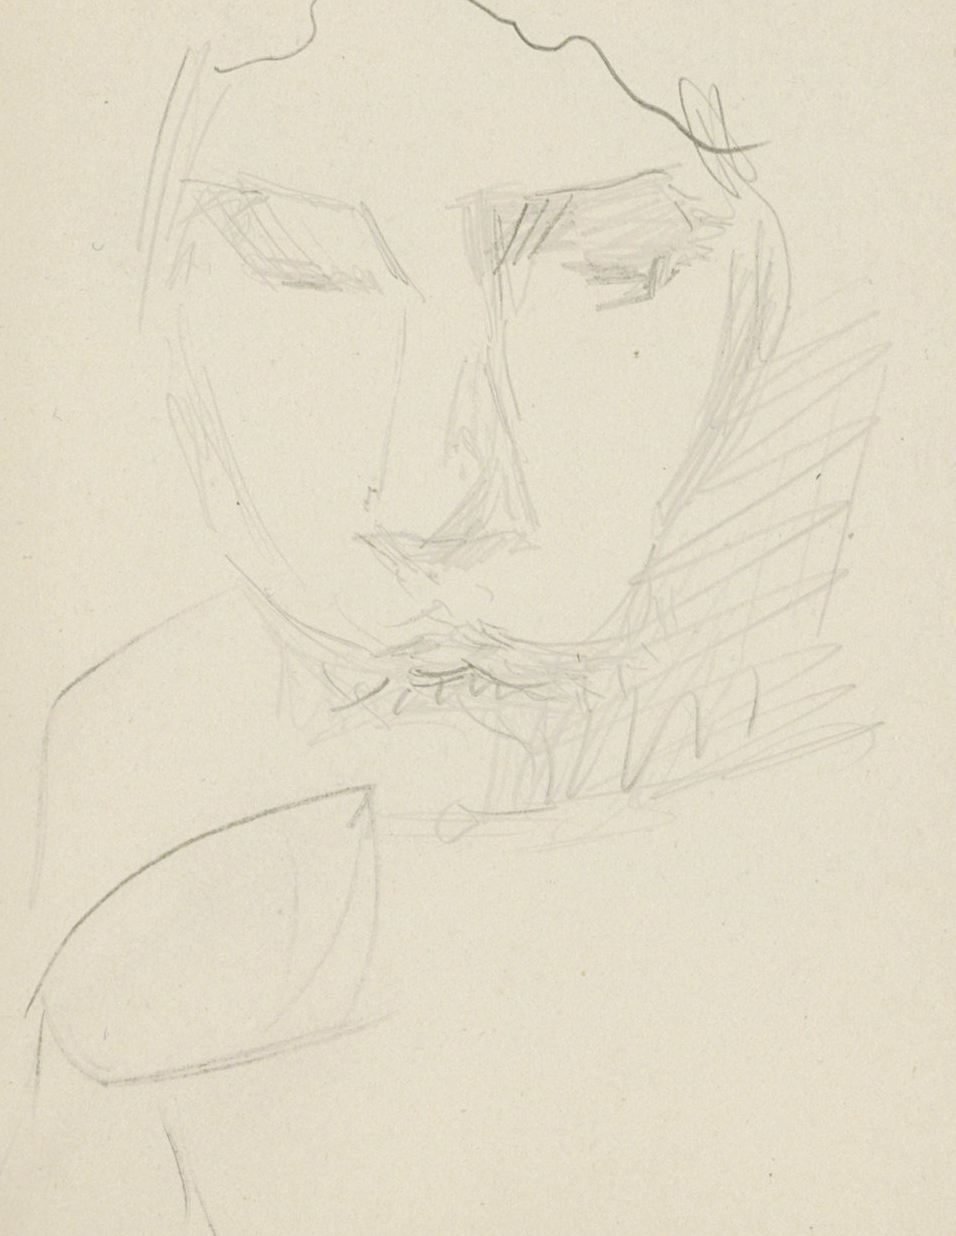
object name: sketchbook leaf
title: Gezicht van een vrouw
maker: reijer stolk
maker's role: draughtsman, print maker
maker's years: 1896-1945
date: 1906-1945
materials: paper, pencil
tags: face - aa - mask (mould taken from face)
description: Blad 30 recto uit een schetsboek met 69 bladen.